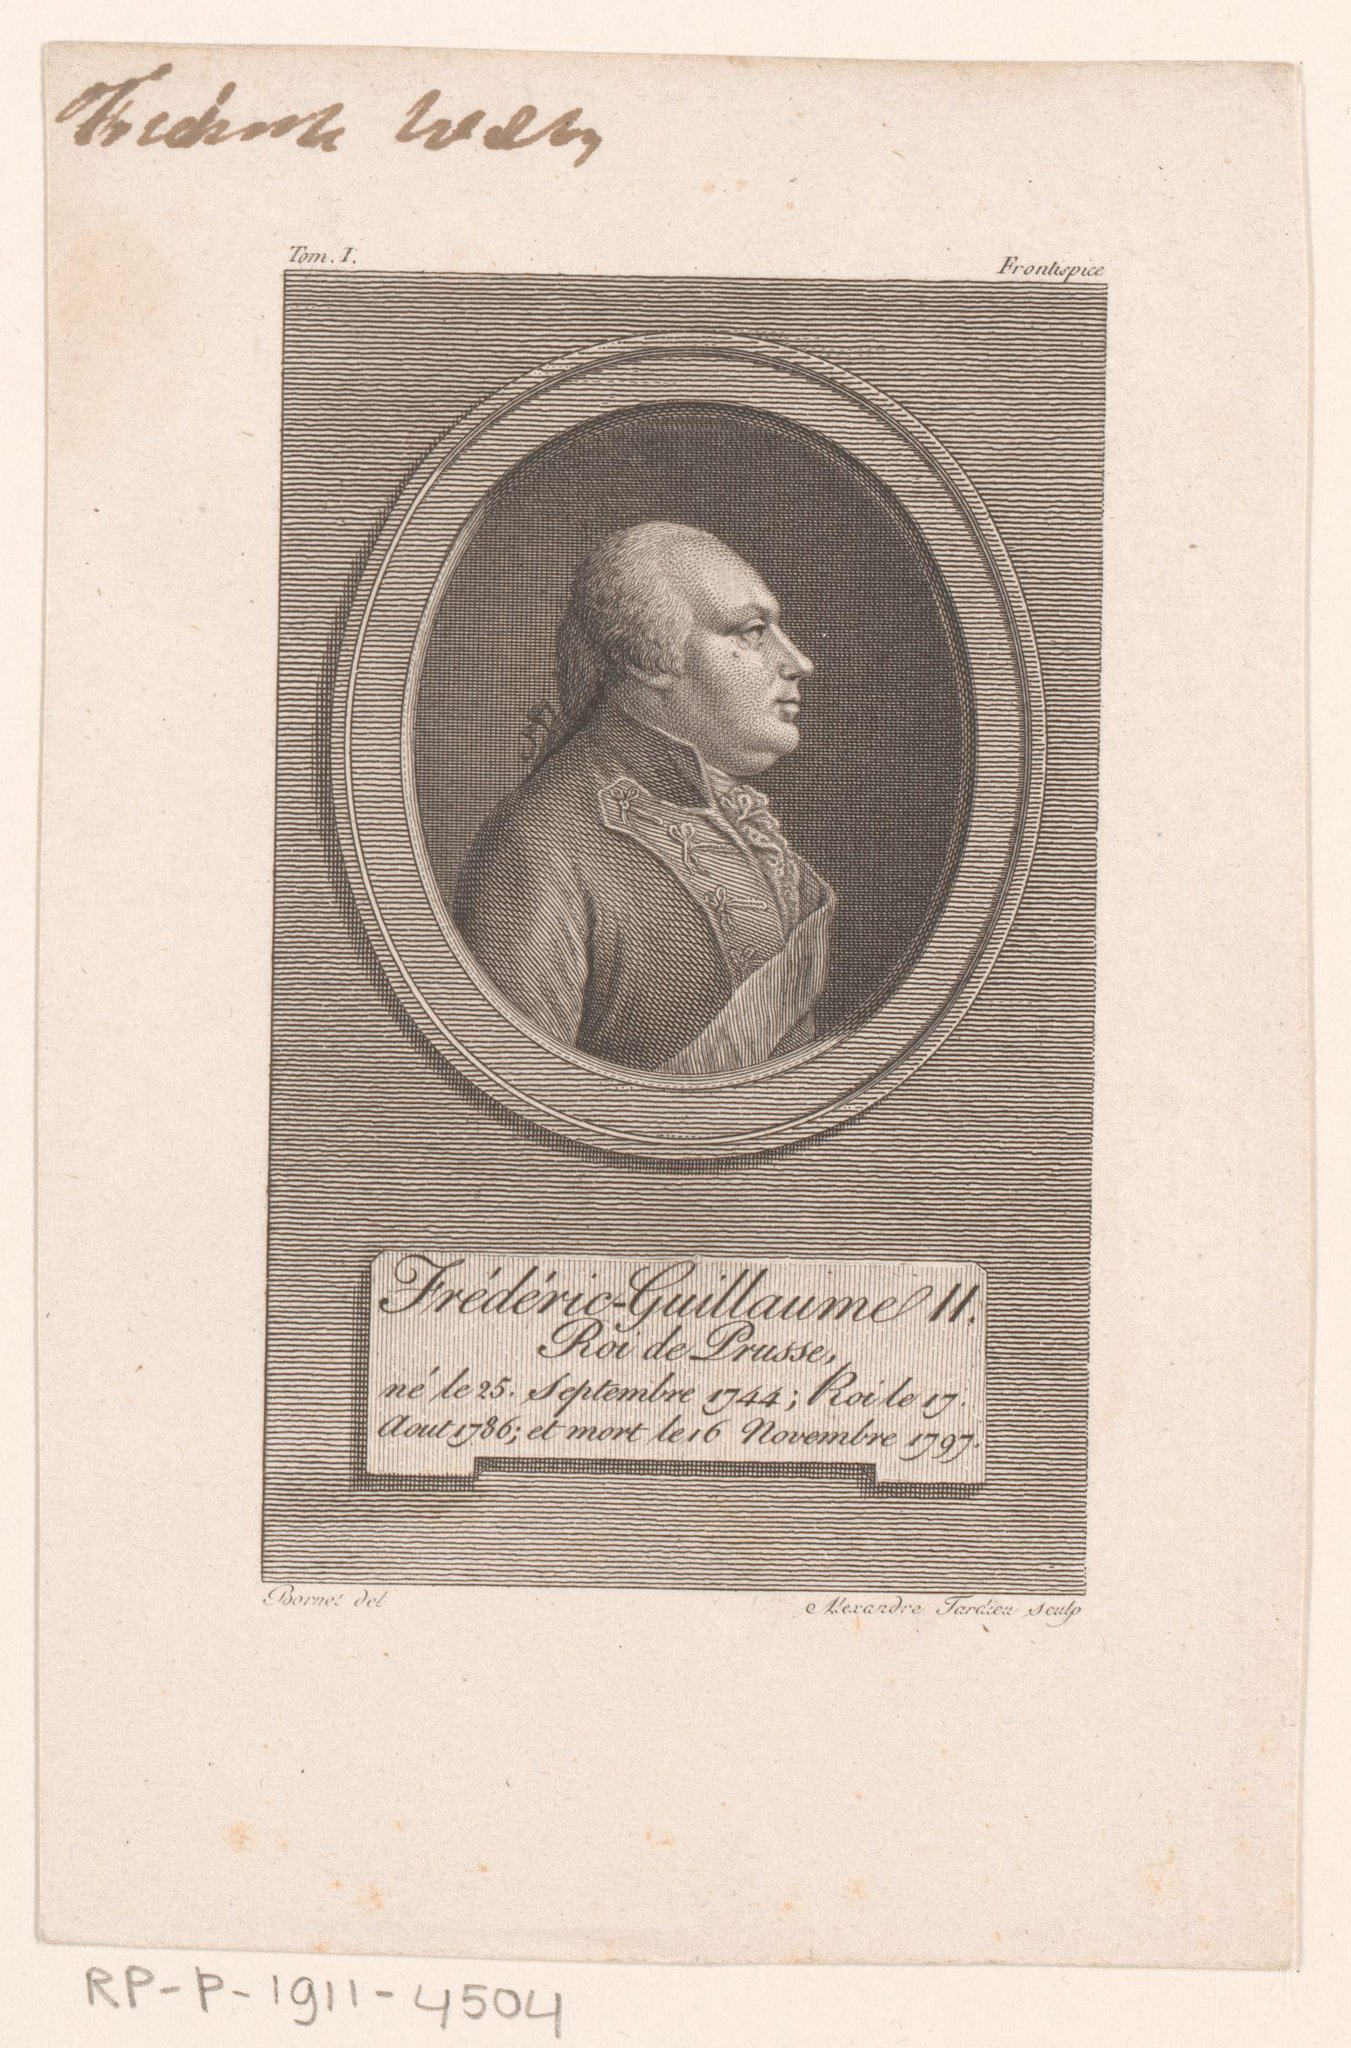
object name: print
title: Portret van koning Frederik Willem II van Pruisen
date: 1766-1844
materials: paper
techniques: engraving, etching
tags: berlin, frederik willem ii (koning van pruisen), historical persons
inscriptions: collector's mark: Lugt 2228